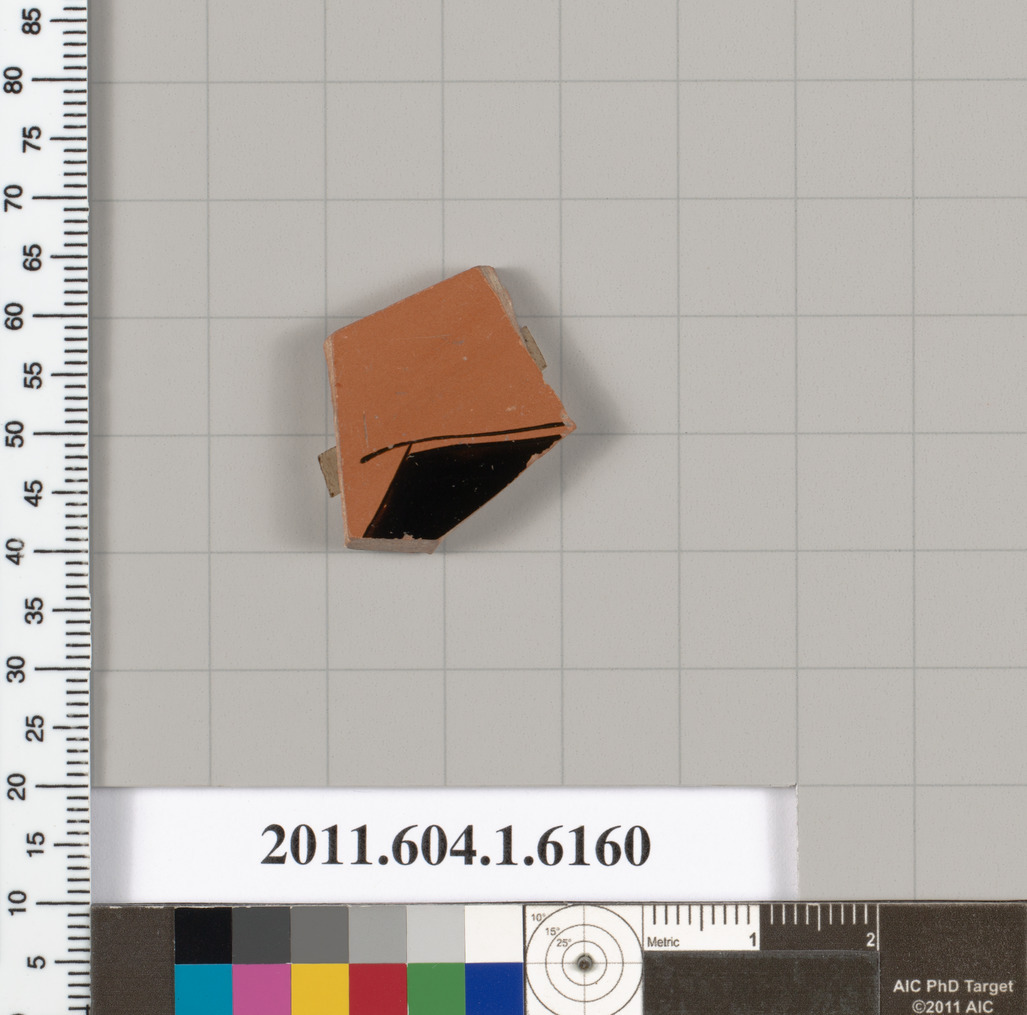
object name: kylix fragment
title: Terracotta fragment of a kylix (drinking cup)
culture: greek, attic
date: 520-500 BCE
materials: terracotta